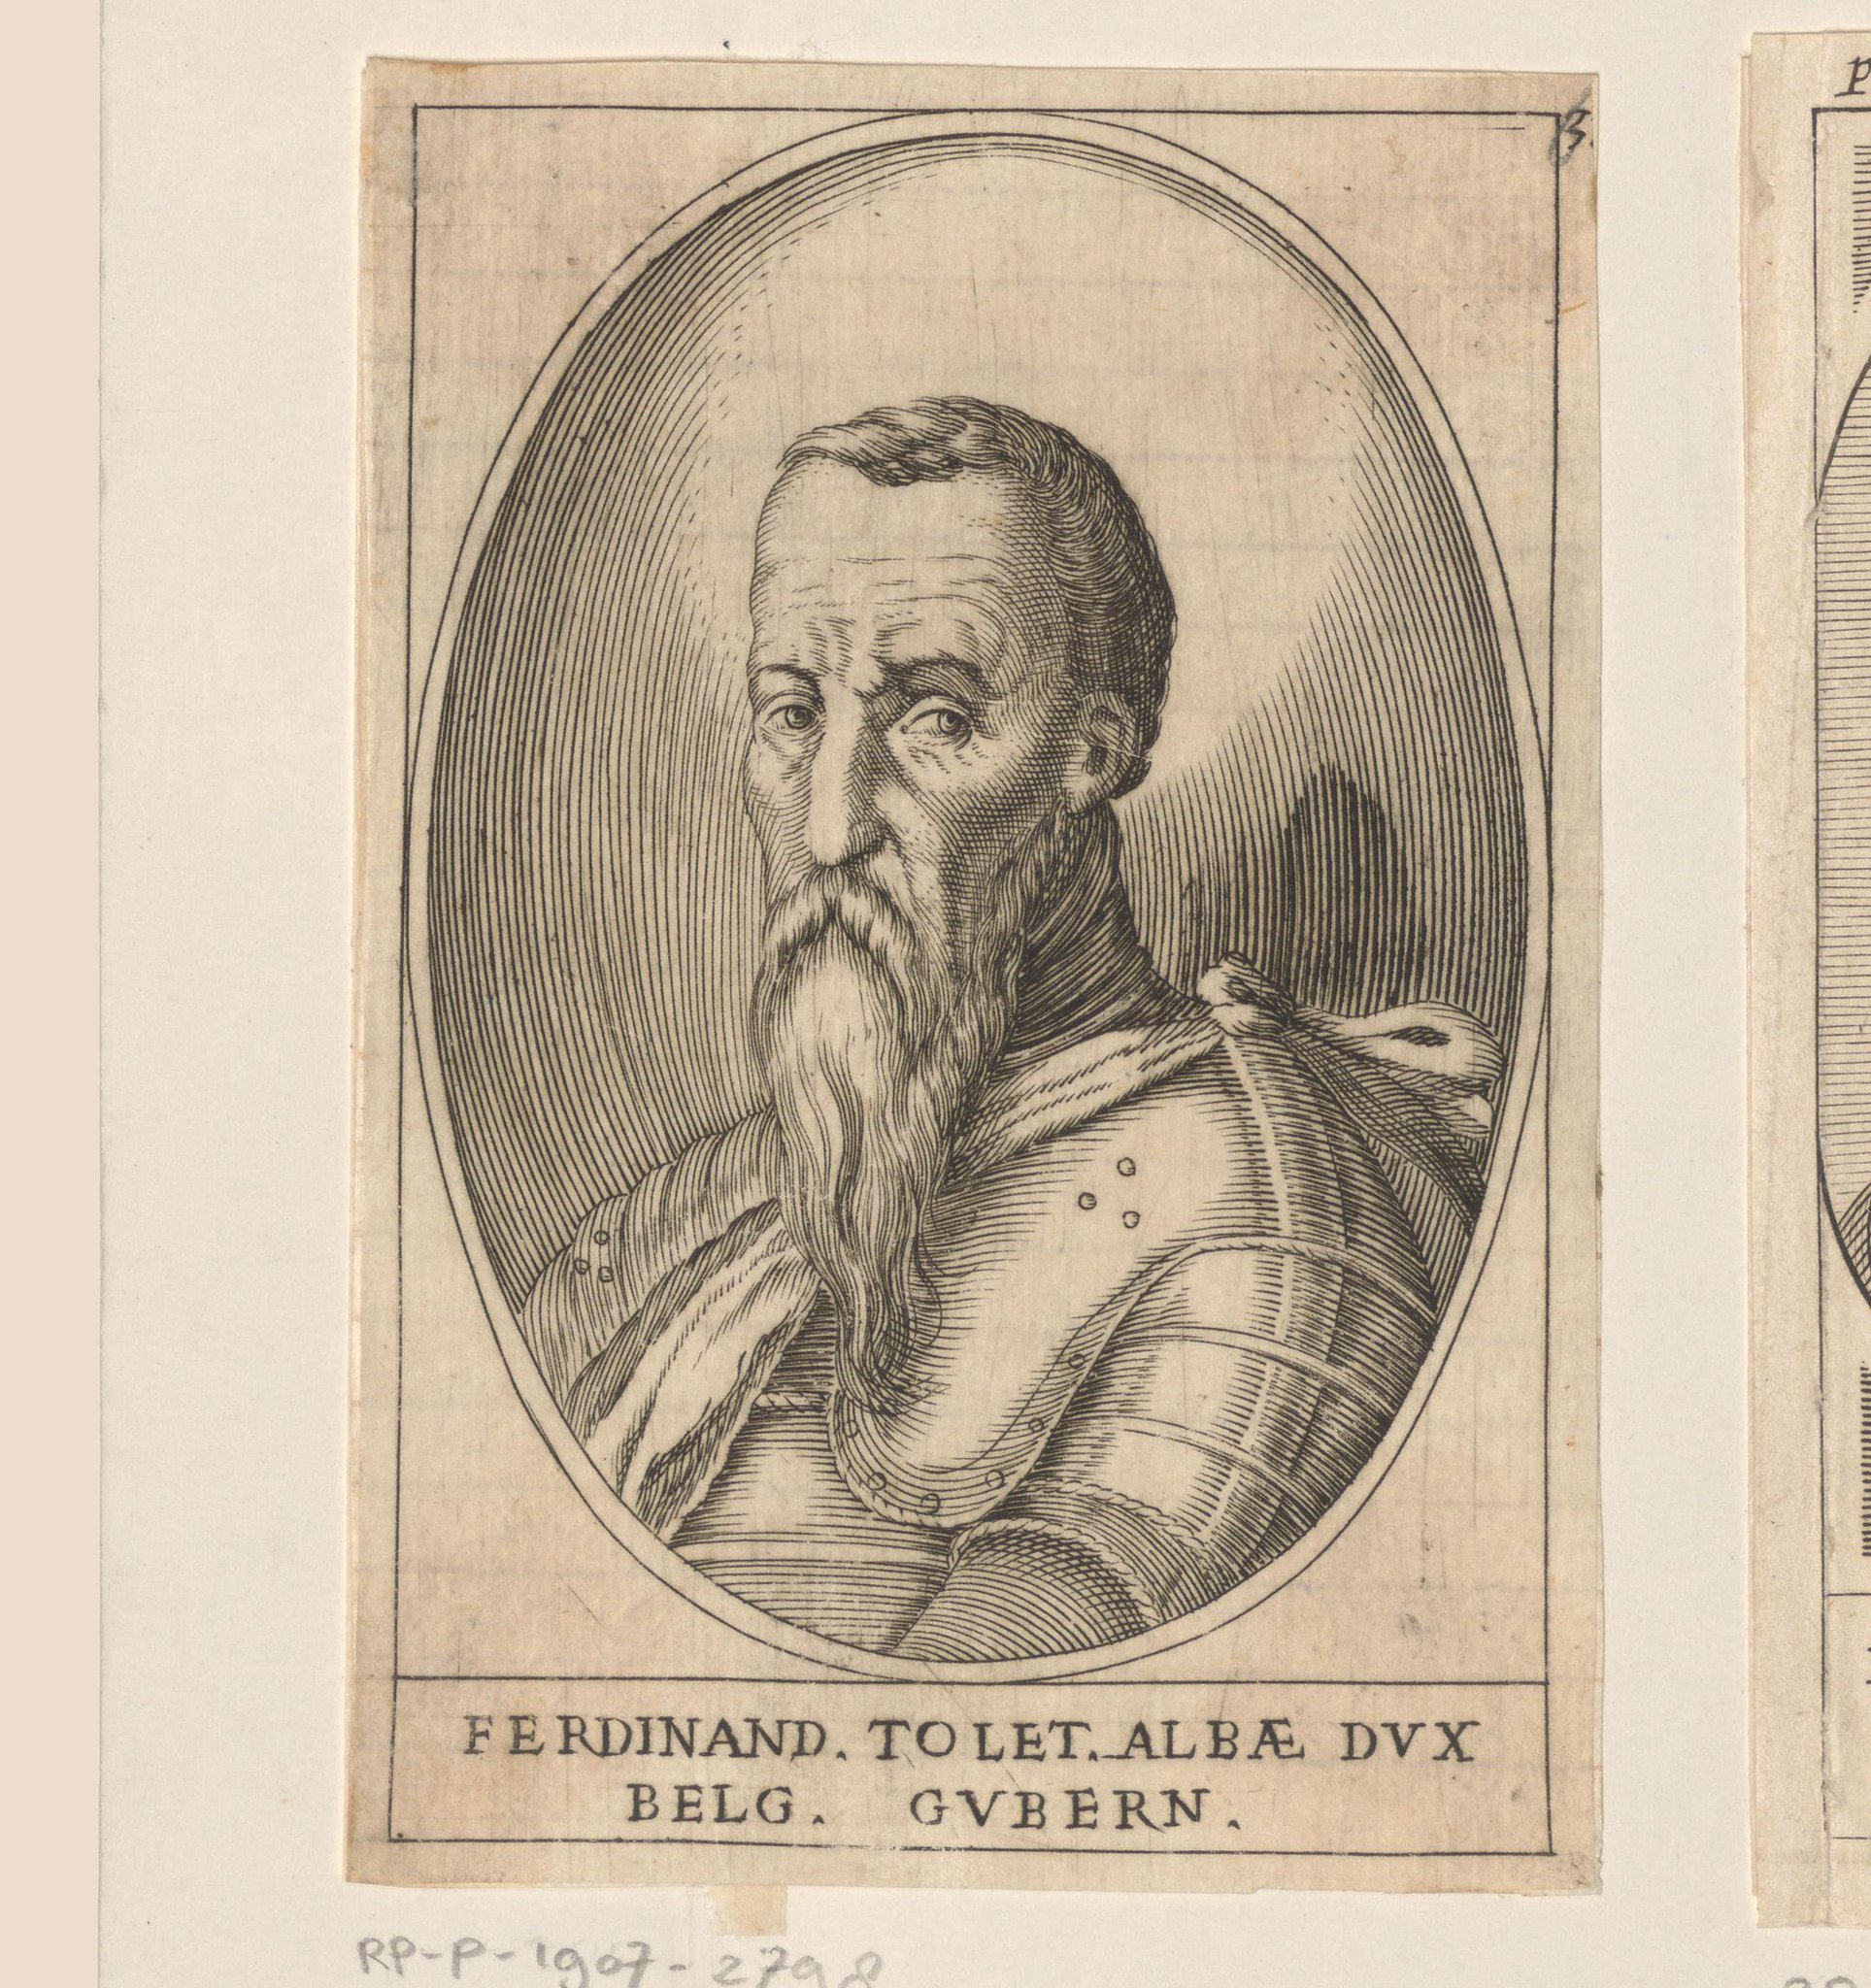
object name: print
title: Portret van Fernando Álvarez de Toledo, hertog van Alva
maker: Anonymous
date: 1650-1699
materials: paper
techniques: engraving, etching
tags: fernando álvarez de toledo (3rd duke of alba), armour, historical persons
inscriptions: collector's mark: Lugt 2228